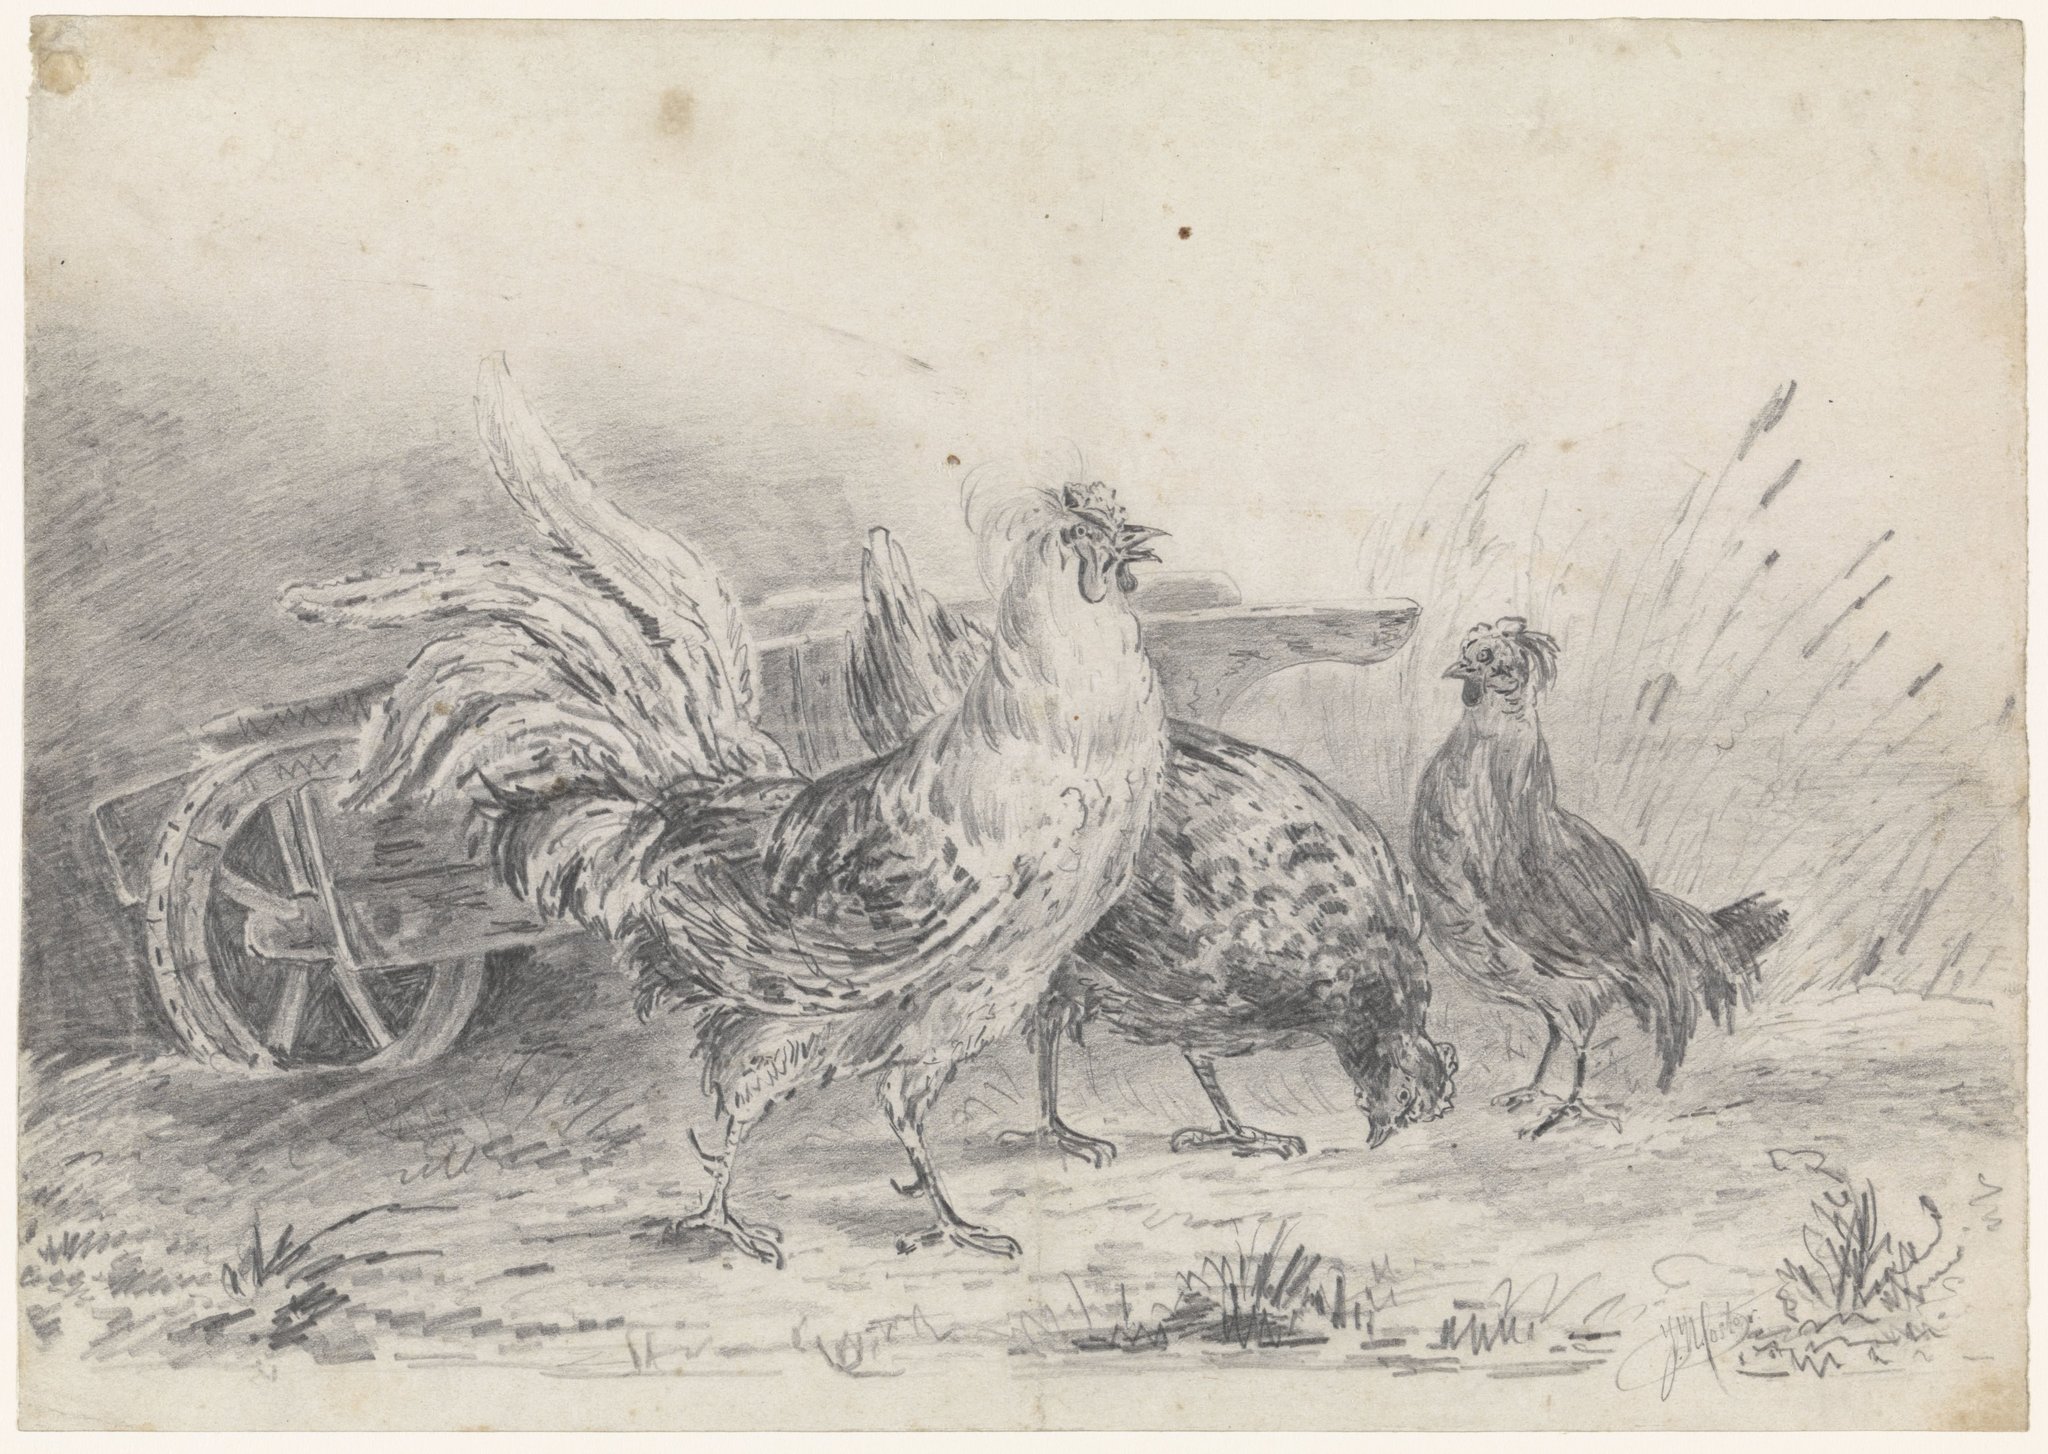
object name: drawing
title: Haan met twee kippen bij een kruiwagen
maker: jan herman coster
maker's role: draughtsman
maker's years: 1846-1920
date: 1856-1920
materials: paper, pencil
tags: fowl (cock, hen, chicken, etc.)